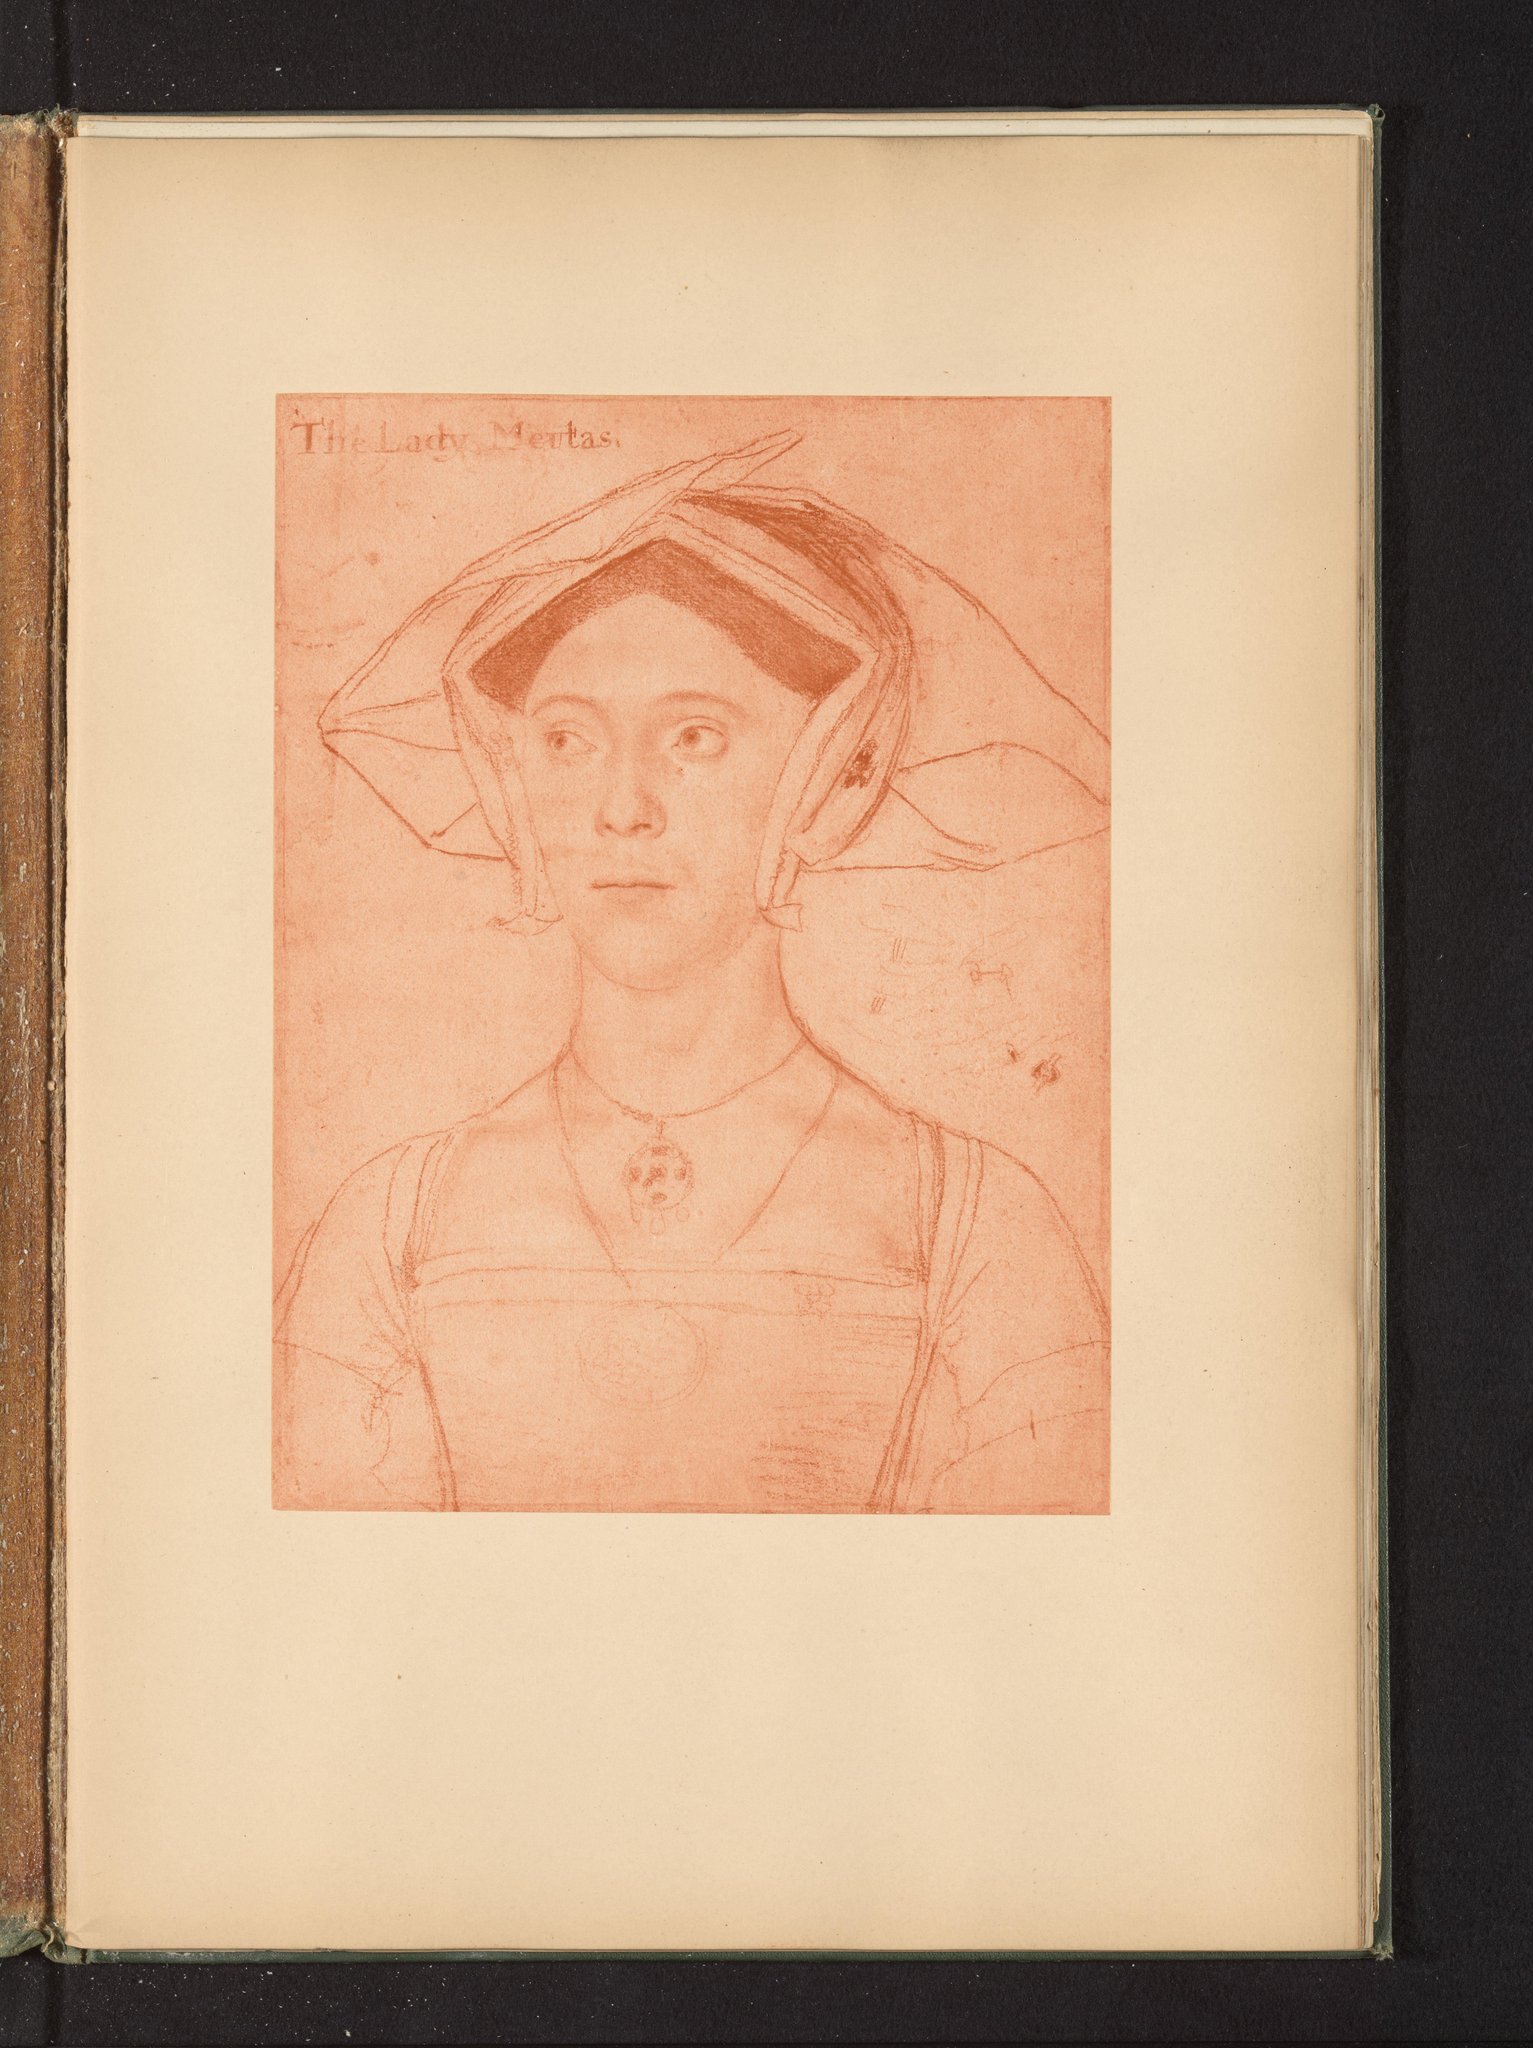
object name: photograph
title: Fotoreproductie van een portret van Joan Meutas door Hans Holbein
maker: Anonymous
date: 1872-1877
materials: paper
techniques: carbon print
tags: drawing, sketch, historical persons - bb - woman